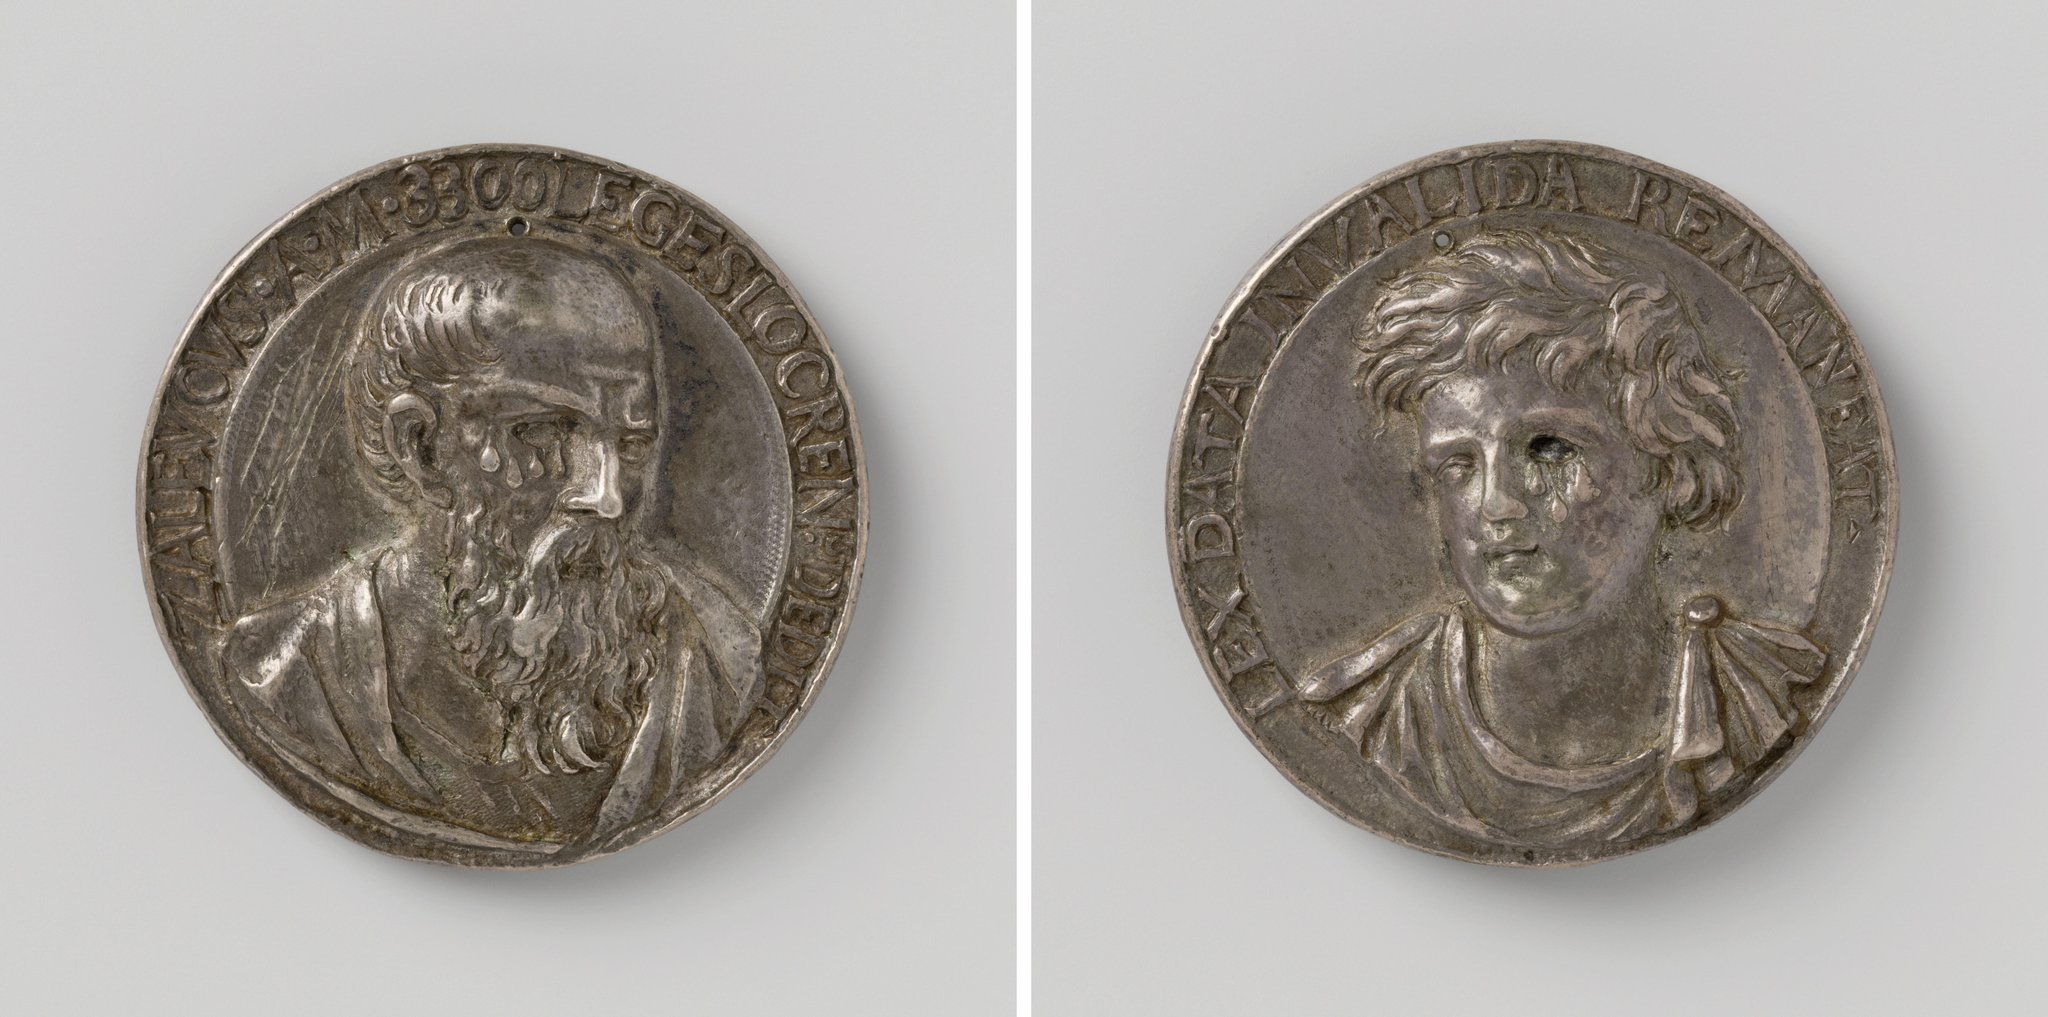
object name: history medal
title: Zaleukos (Zaleucus), Grieks wetgever uit Locri Epizephyrii, en zijn zoon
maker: Anonymous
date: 1500-1600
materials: silver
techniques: striking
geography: germany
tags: zaleukos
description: Zilveren penning. Voorzijde: borststuk man met een uitgestoken oog binnen omschrift. Keerzijde: borststuk jongen met een uitgestoken oog binnen omschrift